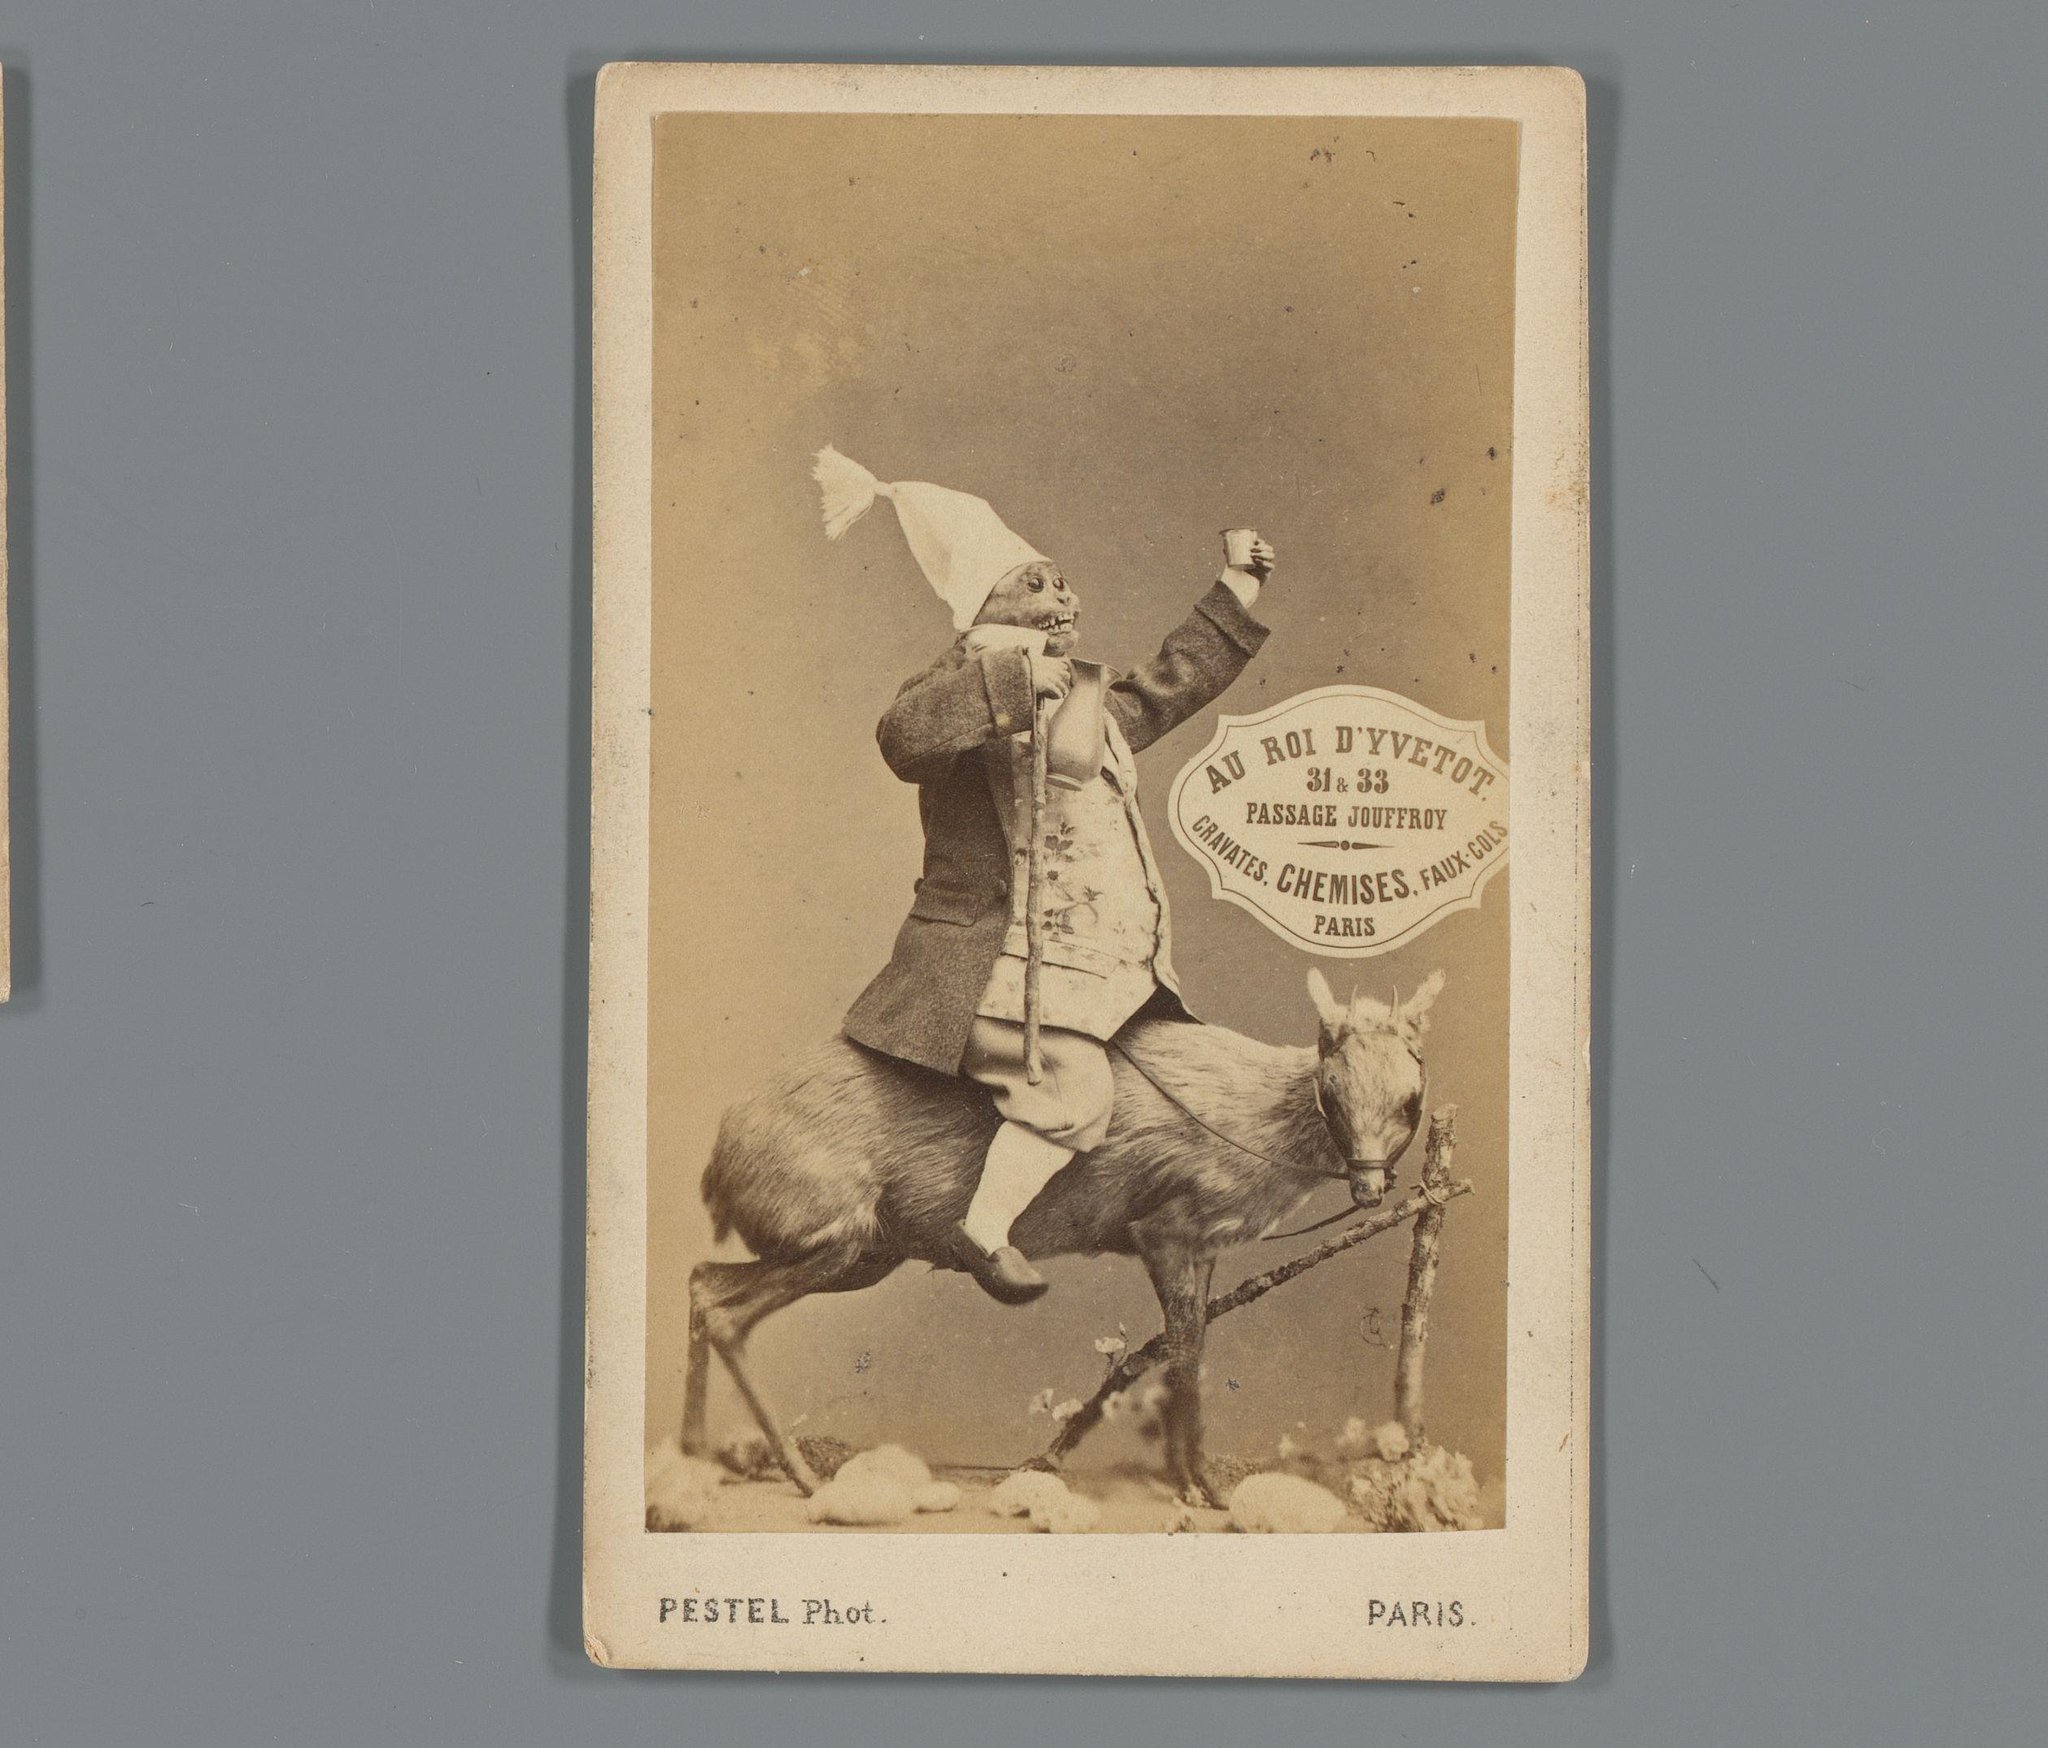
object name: photograph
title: Opgezette aap in kleding zit op een klein hert als reclame voor kledingwinkel Roy d'Yvetot in Parijs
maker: alphonse pestel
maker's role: fotograaf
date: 1850-1915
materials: cardboard, photographic support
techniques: albumen print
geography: paris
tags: advertising, monkeys, apes, clothes manufacture, clothing industry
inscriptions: inscription: ‘AU ROI D'YVETOT,/ 31 & 33/ Passage Jouffroy./ (...)/ MAISON VILLAIN/ V. GARRET Sr./ 31 et 33 Passage Jouffroy/ PARIS/ PORTAITS/ en tous genres/ PHOTOGRAPHIE/ DE LA/ PORTE St. DENIS/ PESTEL,/ Boult. Bonne Nouvelle, 3./ PARIS/ REPRODUCTIONS’, inscription: ‘PESTEL Phot. PARIS.’